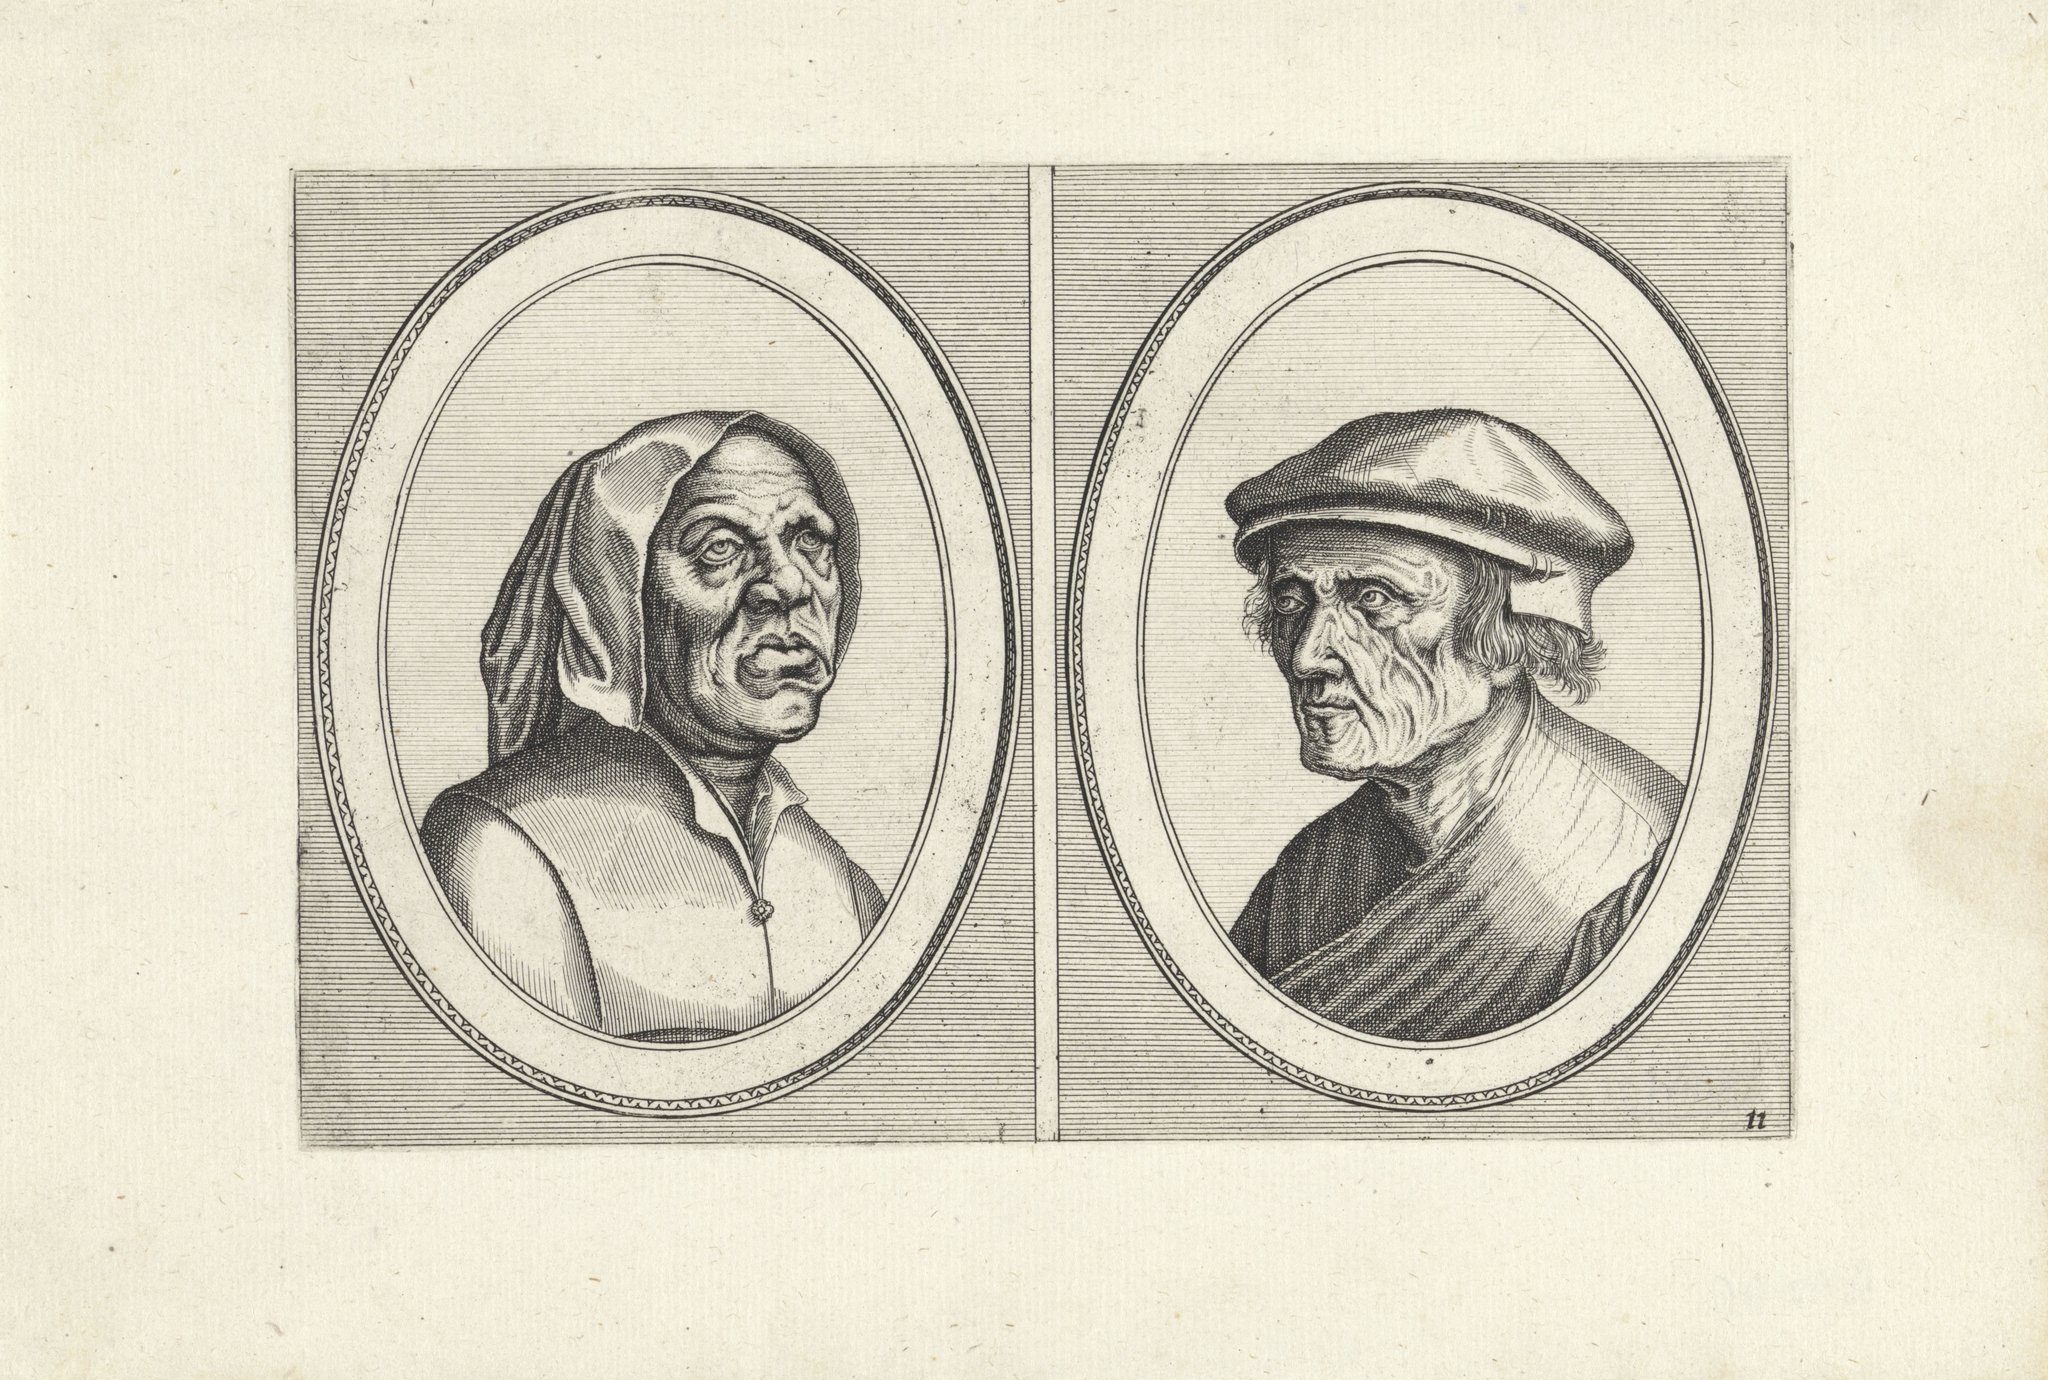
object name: print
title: Boerenkoppen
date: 1612-1652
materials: paper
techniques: engraving, etching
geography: amsterdam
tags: head-gear, farmers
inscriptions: collector's mark: Lugt 2228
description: Prent uit een serie van 36 prenten met koppen van boeren en boerinnen.